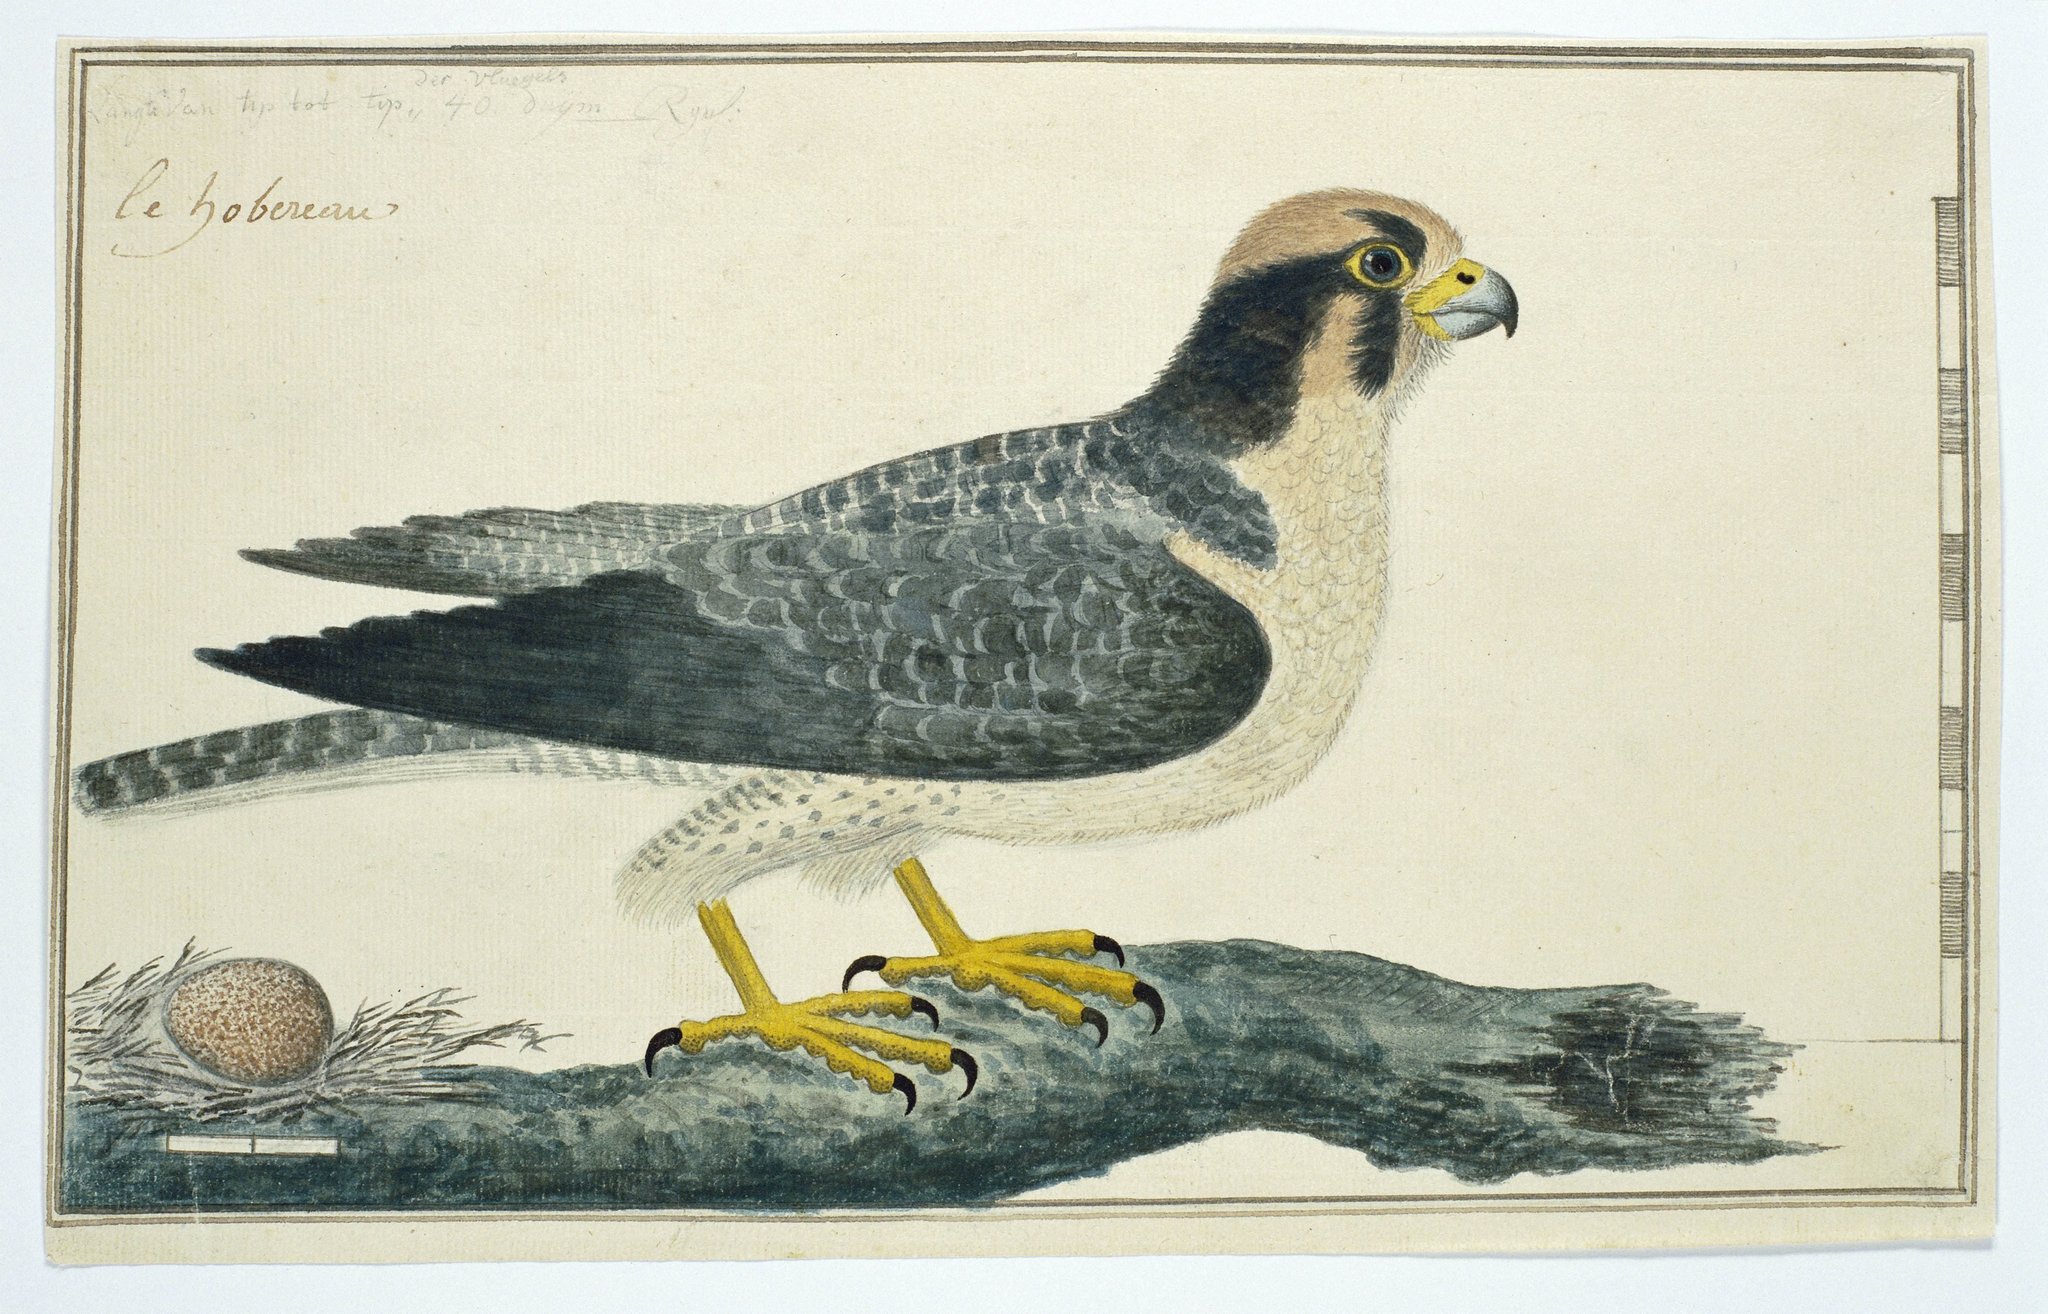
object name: album leaf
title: Falco biarmicus ? (Lanner falcon)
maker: robert jacob gordon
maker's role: draughtsman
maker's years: 1743-1795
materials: chalk, ink, paper, pencil, watercolor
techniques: brush, pen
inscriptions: annotation: ‘le hobereau; afmetingen’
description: Vogelstudie: Edelvalk (Falco biarmicus) op een boomtak met een roodgespikkeld ei linksonder; met schaalindeling in Rijnlandse maten.